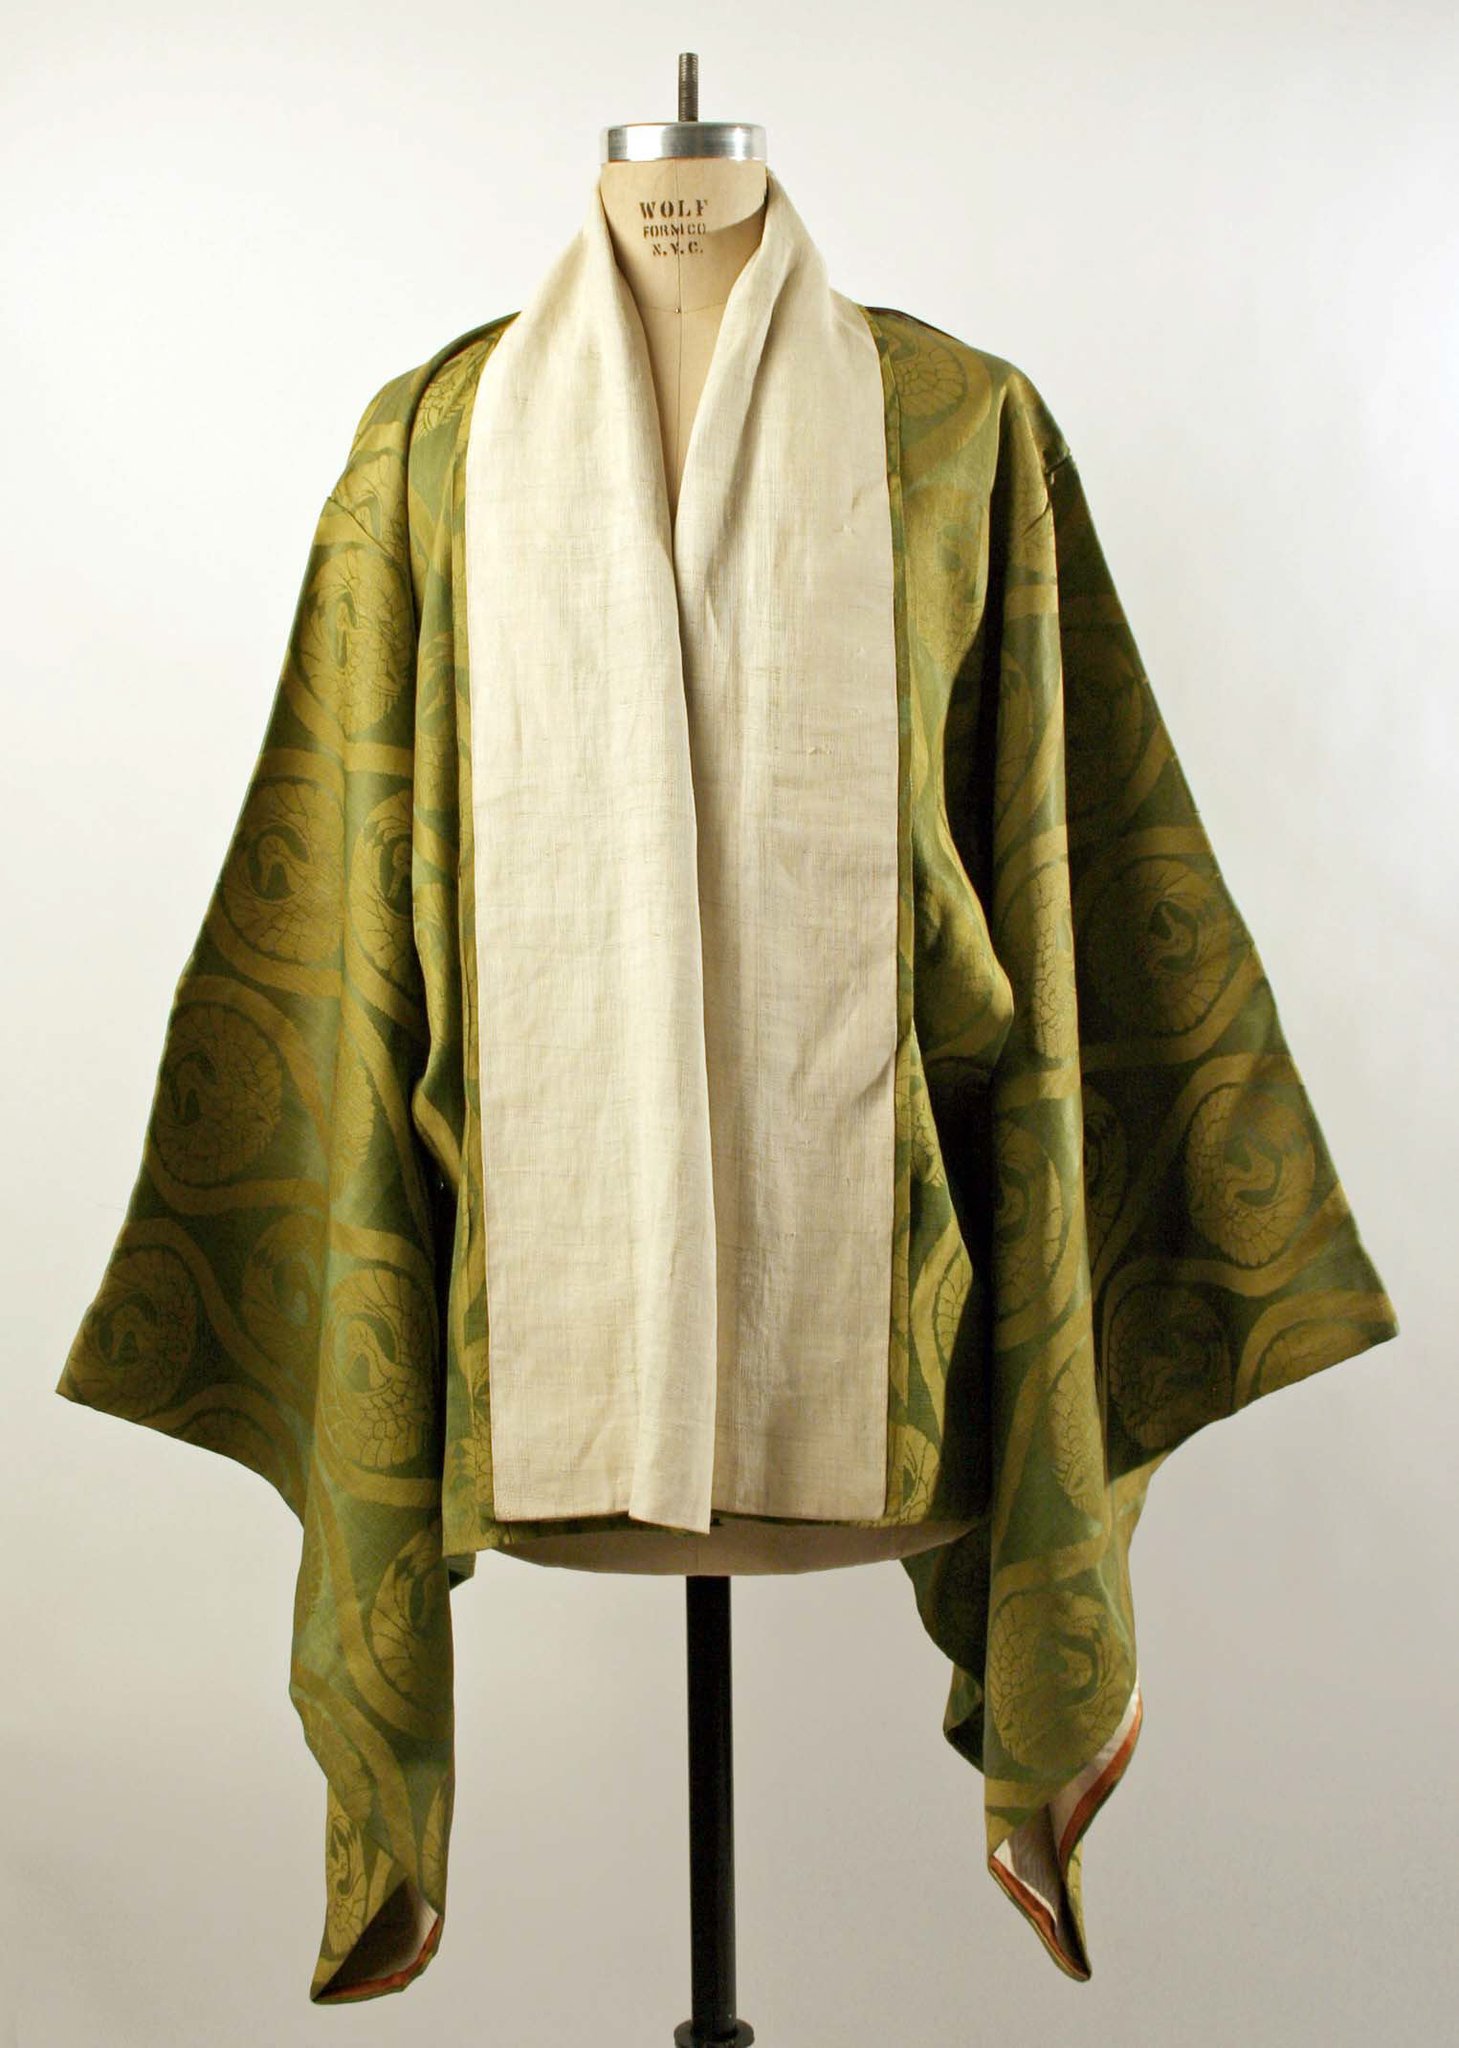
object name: theatrical costume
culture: japanese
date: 1801-1900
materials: cotton, paper, silk